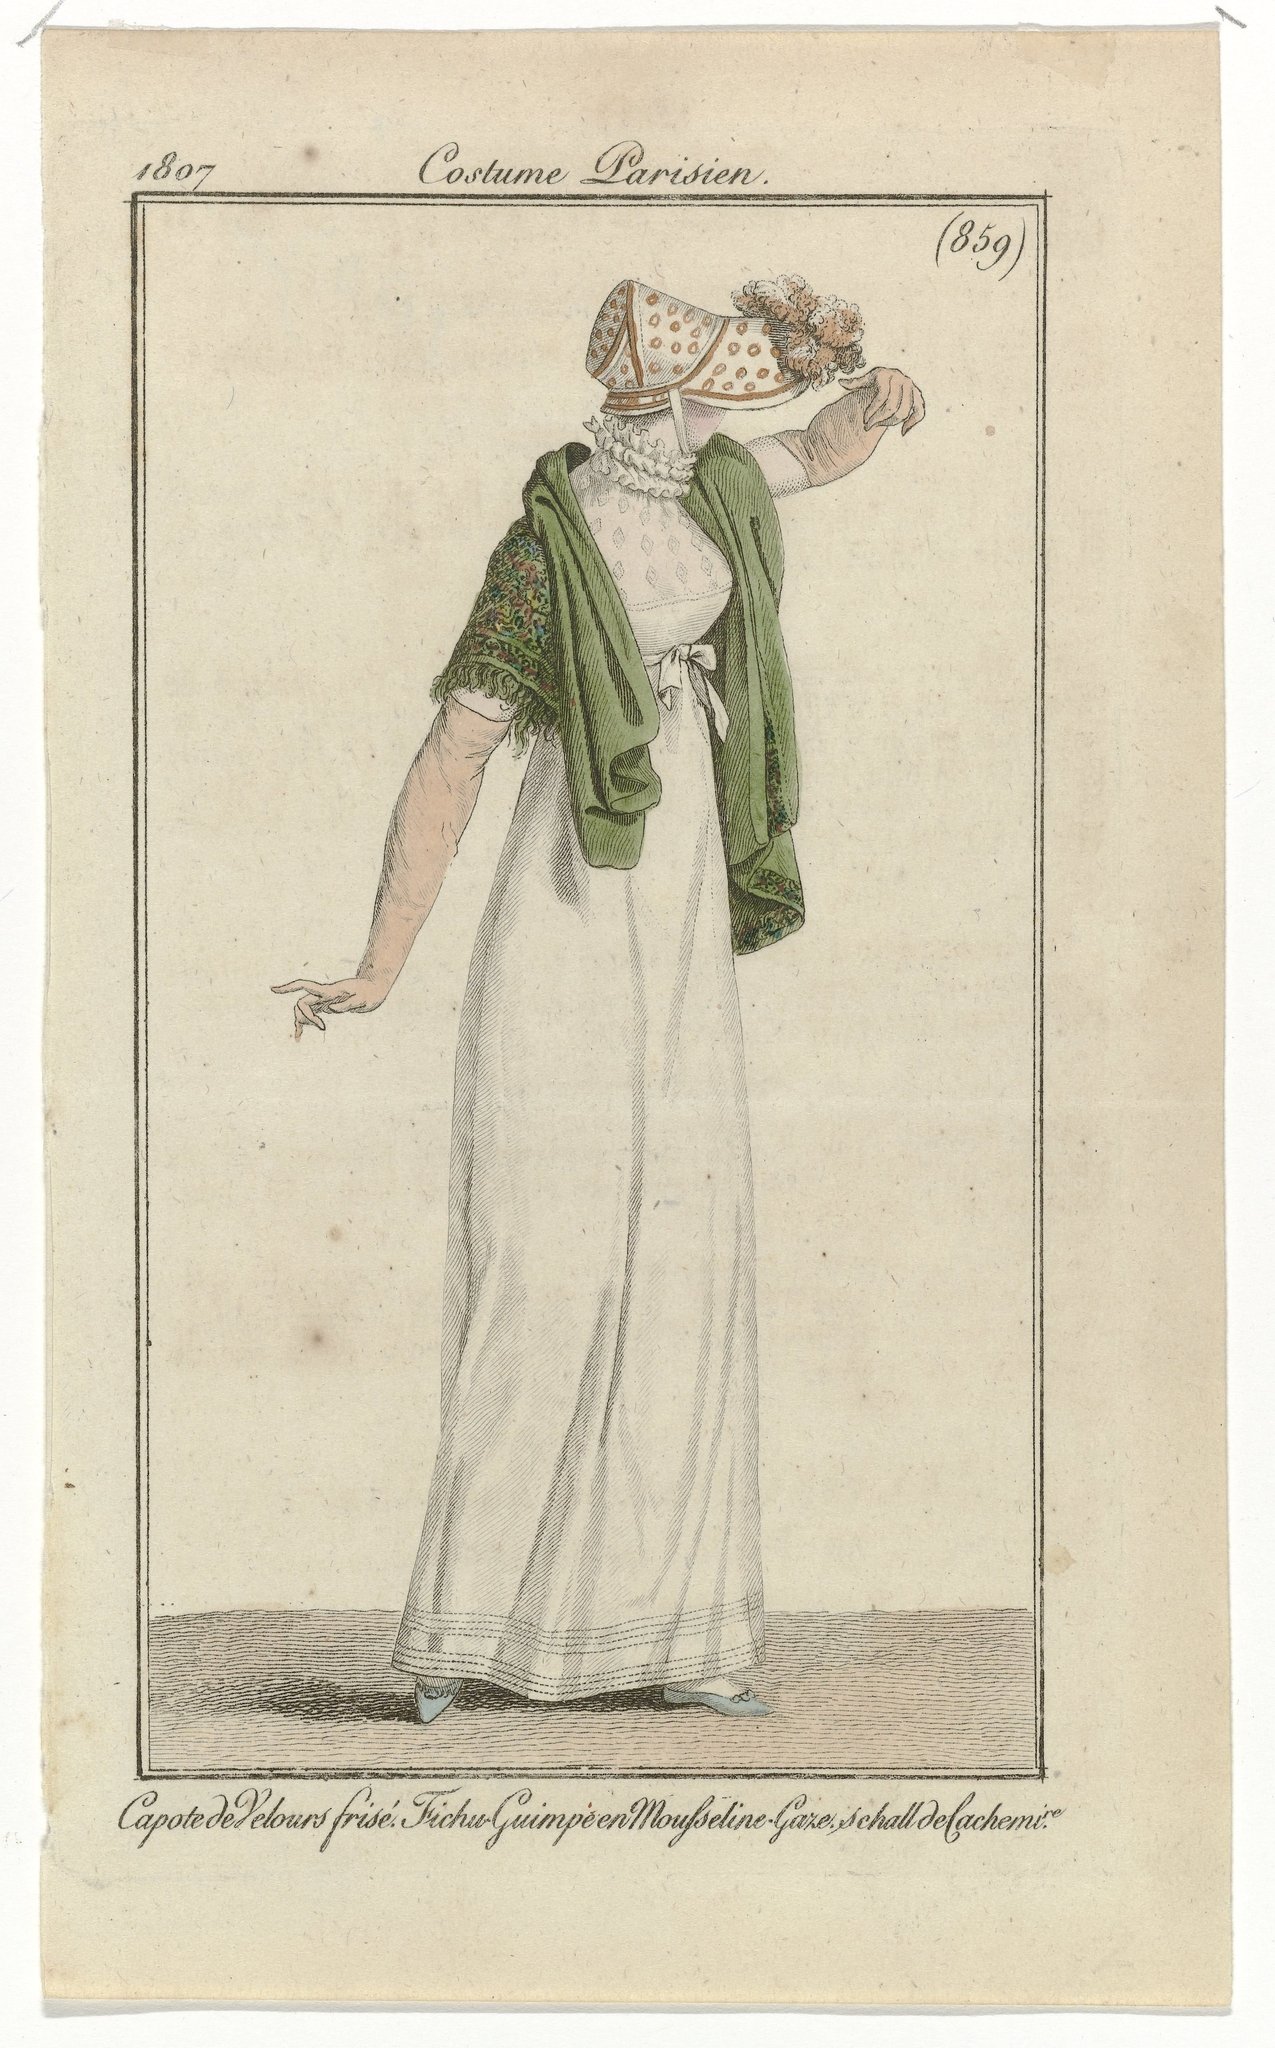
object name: fashion print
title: Journal des Dames et des Modes, Costume Parisien, 25 décembre 1807, (859): Capote de Velours frisé (...)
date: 1807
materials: paper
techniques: engraving, hand coloring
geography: paris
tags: head-gear (capote) (+ women's clothes), gloves, mittens (long gloves) (+ women's clothes), clothing for the upper part of the body (shawl) (+ women's clothes), piece of clothing covering the breast or décolleté (guimpe) (+ women's clothes), fashion plates, shoes, sandals (+ women's clothes), dress, gown (+ women's clothes), piece of clothing covering the breast or décolleté (fichu) (+ women's clothes)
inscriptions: title: ‘Costume Parisien.’, caption: ‘Capote de Velours frisé. Fichu Guimpe en Mousseline-Gaze, schall de Cachemire.’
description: Vrouw, lopend naar rechts, met op het hoofd een 'capote' van 'velours frisé'(fluweel). Zij draagt een japon en 'fichu-guimpe' van 'mousseline-gaze'. Om de schouders een sjaal van kasjmier, afgezet met franjes. Verdere accessoires: lange handschoenen, ceintuur(?), platte schoenen. De prent maakt deel uit van het modetijdschrift Journal des Dames et des Modes, uitgegeven door Pierre de la Mésangère, Parijs, 1797-1839.